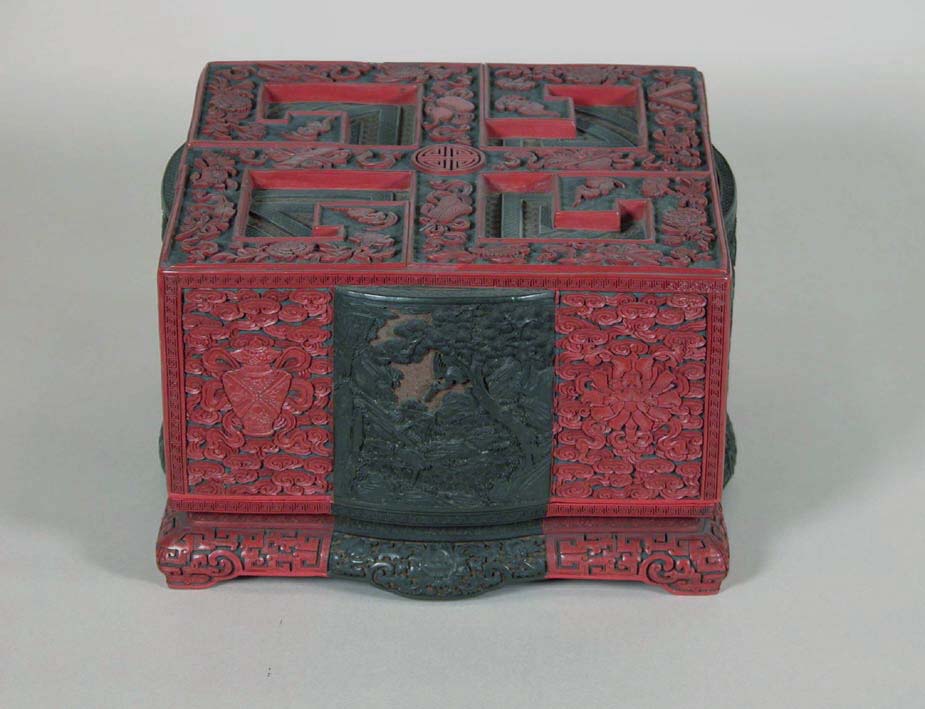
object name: box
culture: chinese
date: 1701-1800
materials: lacquer